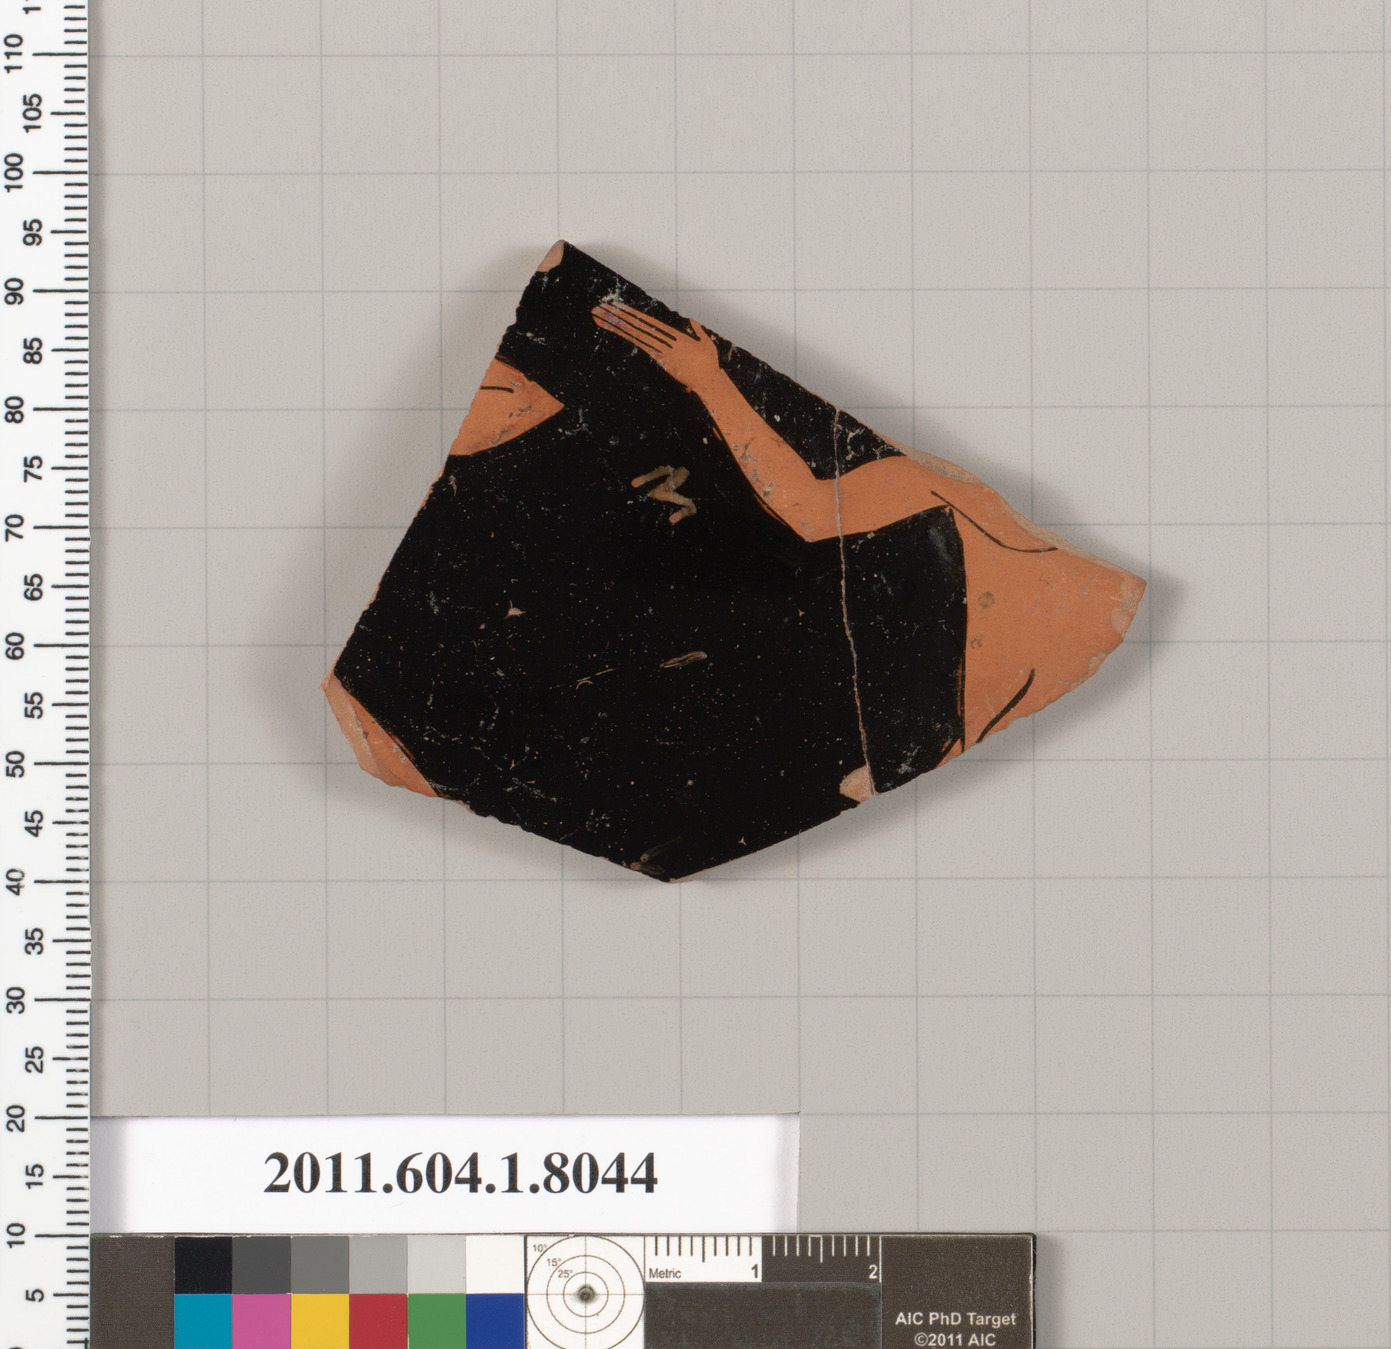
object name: kylix fragment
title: Terracotta fragment of a kylix (drinking cup)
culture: greek, attic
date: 510-500 BCE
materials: terracotta